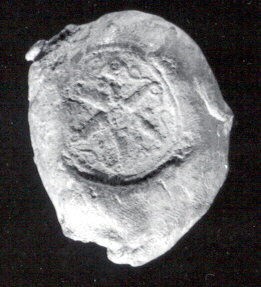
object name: sealing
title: Sealing with stamp seal impressions: radiating griffins; banquet scene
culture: assyrian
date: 1800-1701 BCE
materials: ceramic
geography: anatolia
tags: griffins